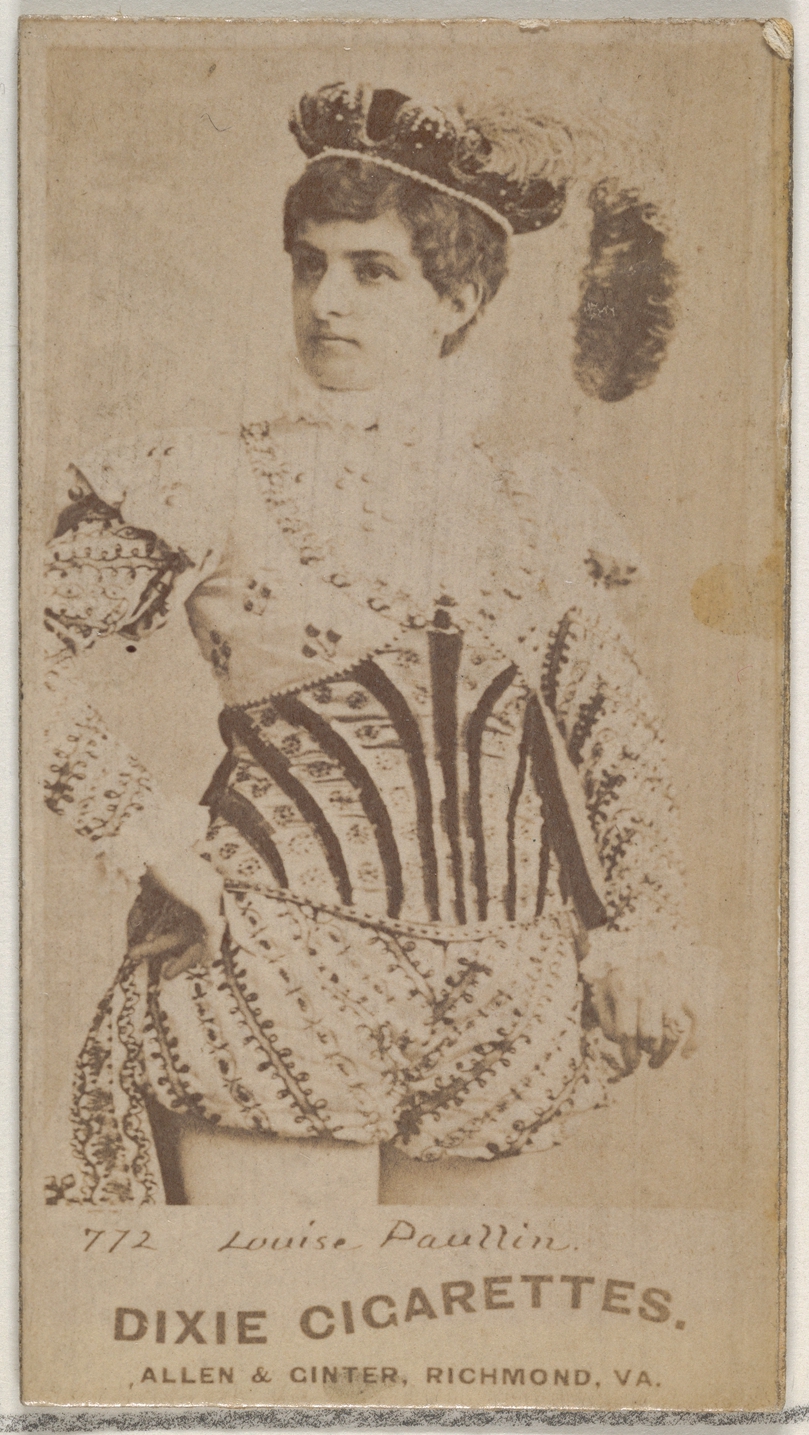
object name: photograph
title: Card 772, Louise Paullin, from the Actors and Actresses series (N45, Type 7) for Dixie Cigarettes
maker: allen & ginter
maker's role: publisher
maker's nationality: american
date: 1888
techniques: albumen silver print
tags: portraits,women,actresses